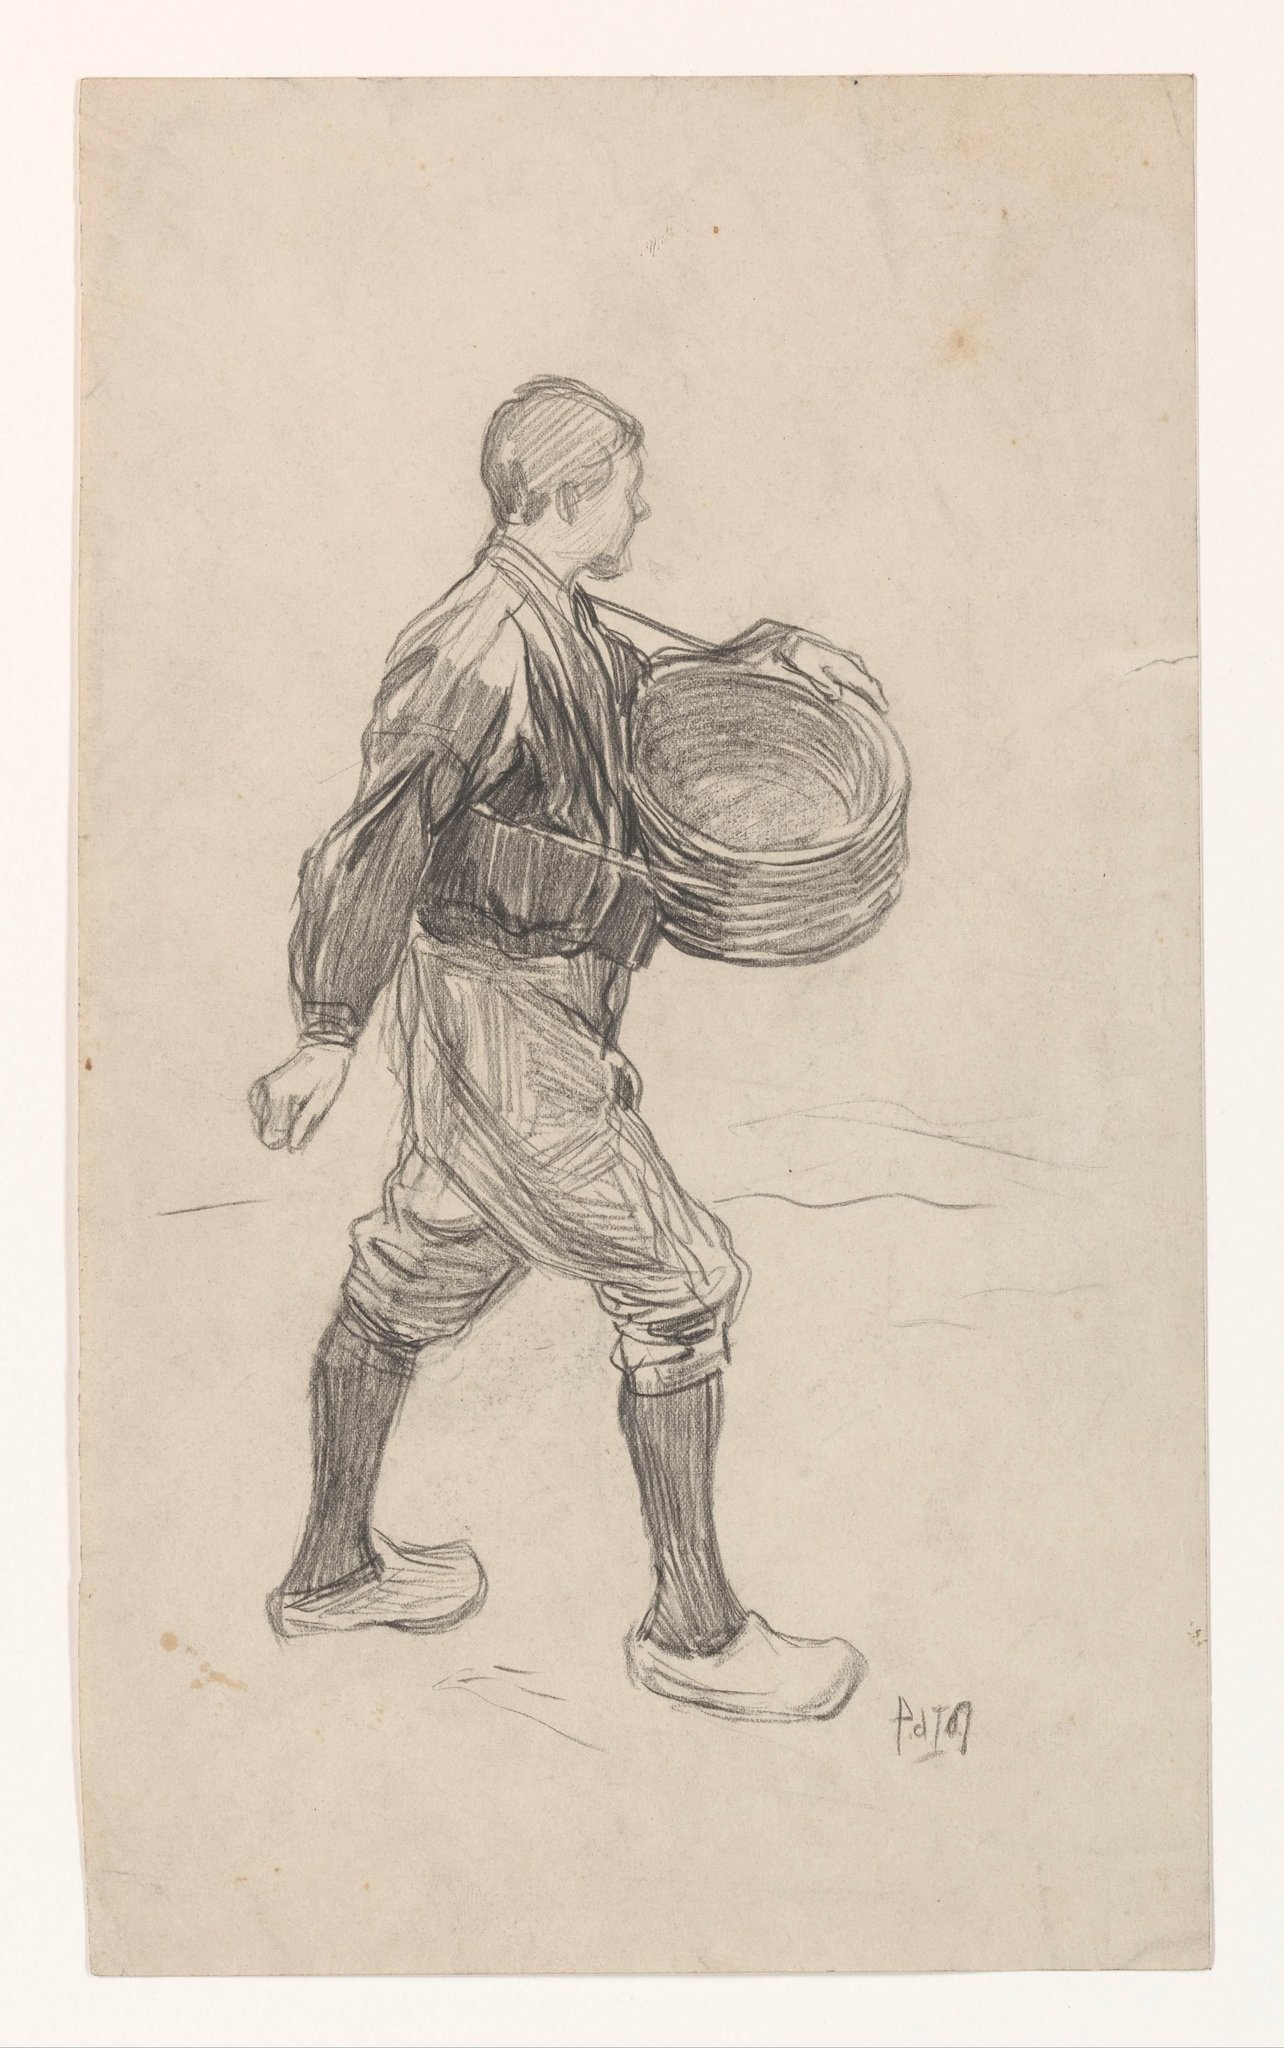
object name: drawing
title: De zaaier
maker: pieter de josselin de jong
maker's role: draughtsman, painter, print maker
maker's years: 1861-1906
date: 1871-1906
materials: chalk, paper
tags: sowing